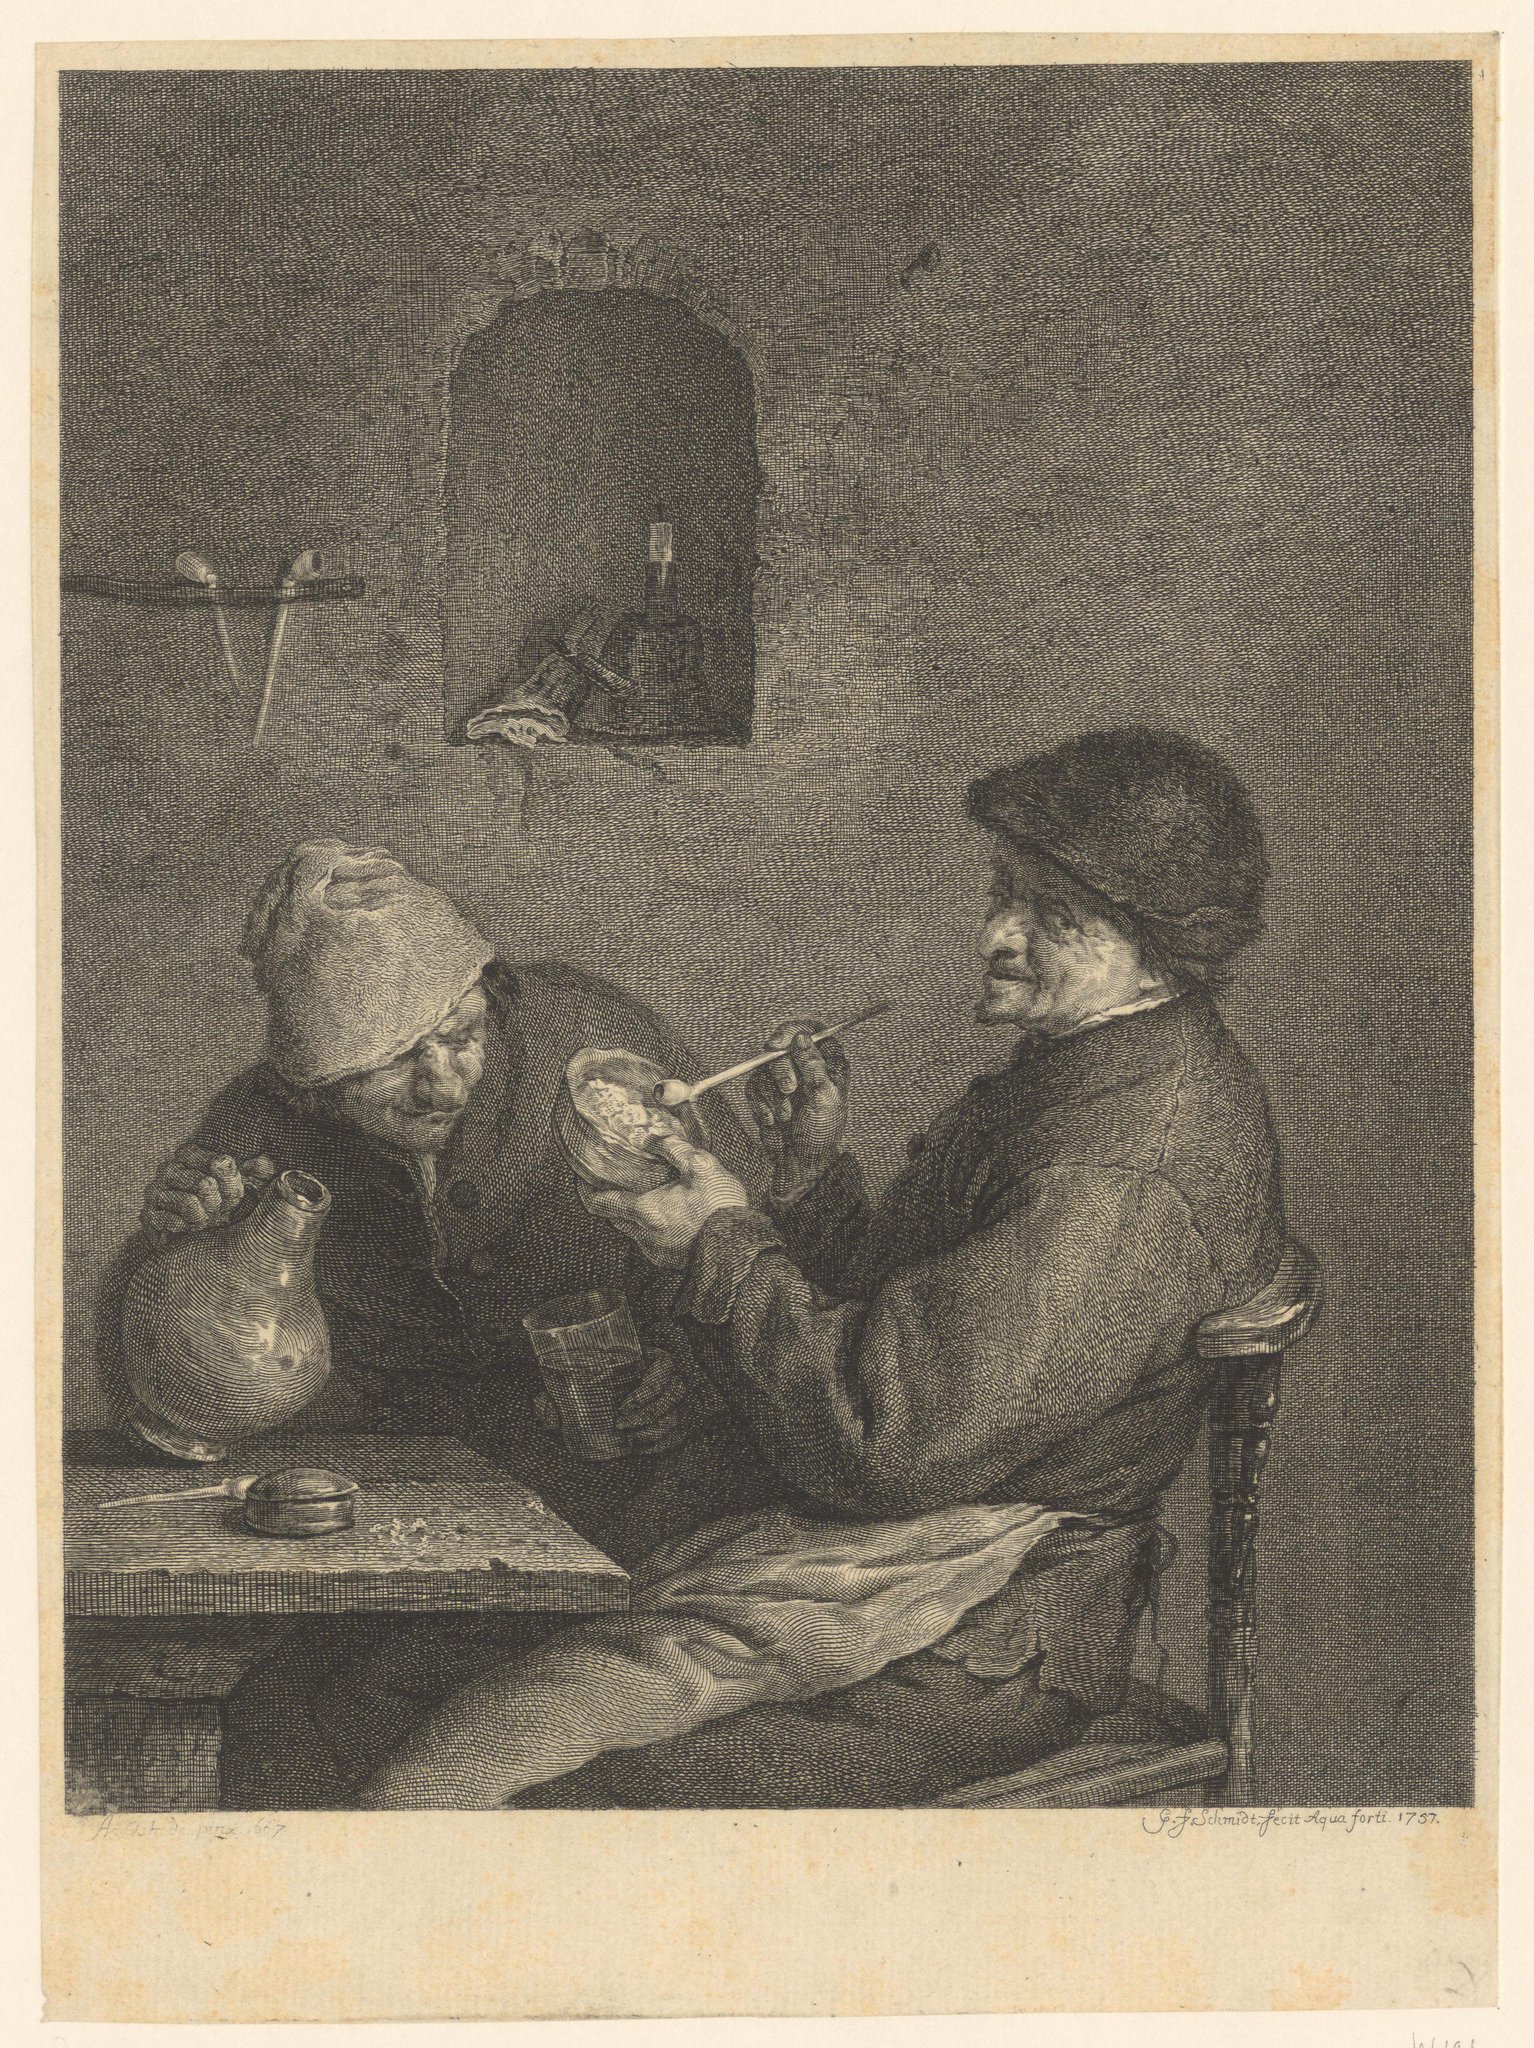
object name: print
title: Roker en drinker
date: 1757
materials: paper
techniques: etching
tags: pipe ~ tobacco, alcoholic drinks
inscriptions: collector's mark: Lugt 240